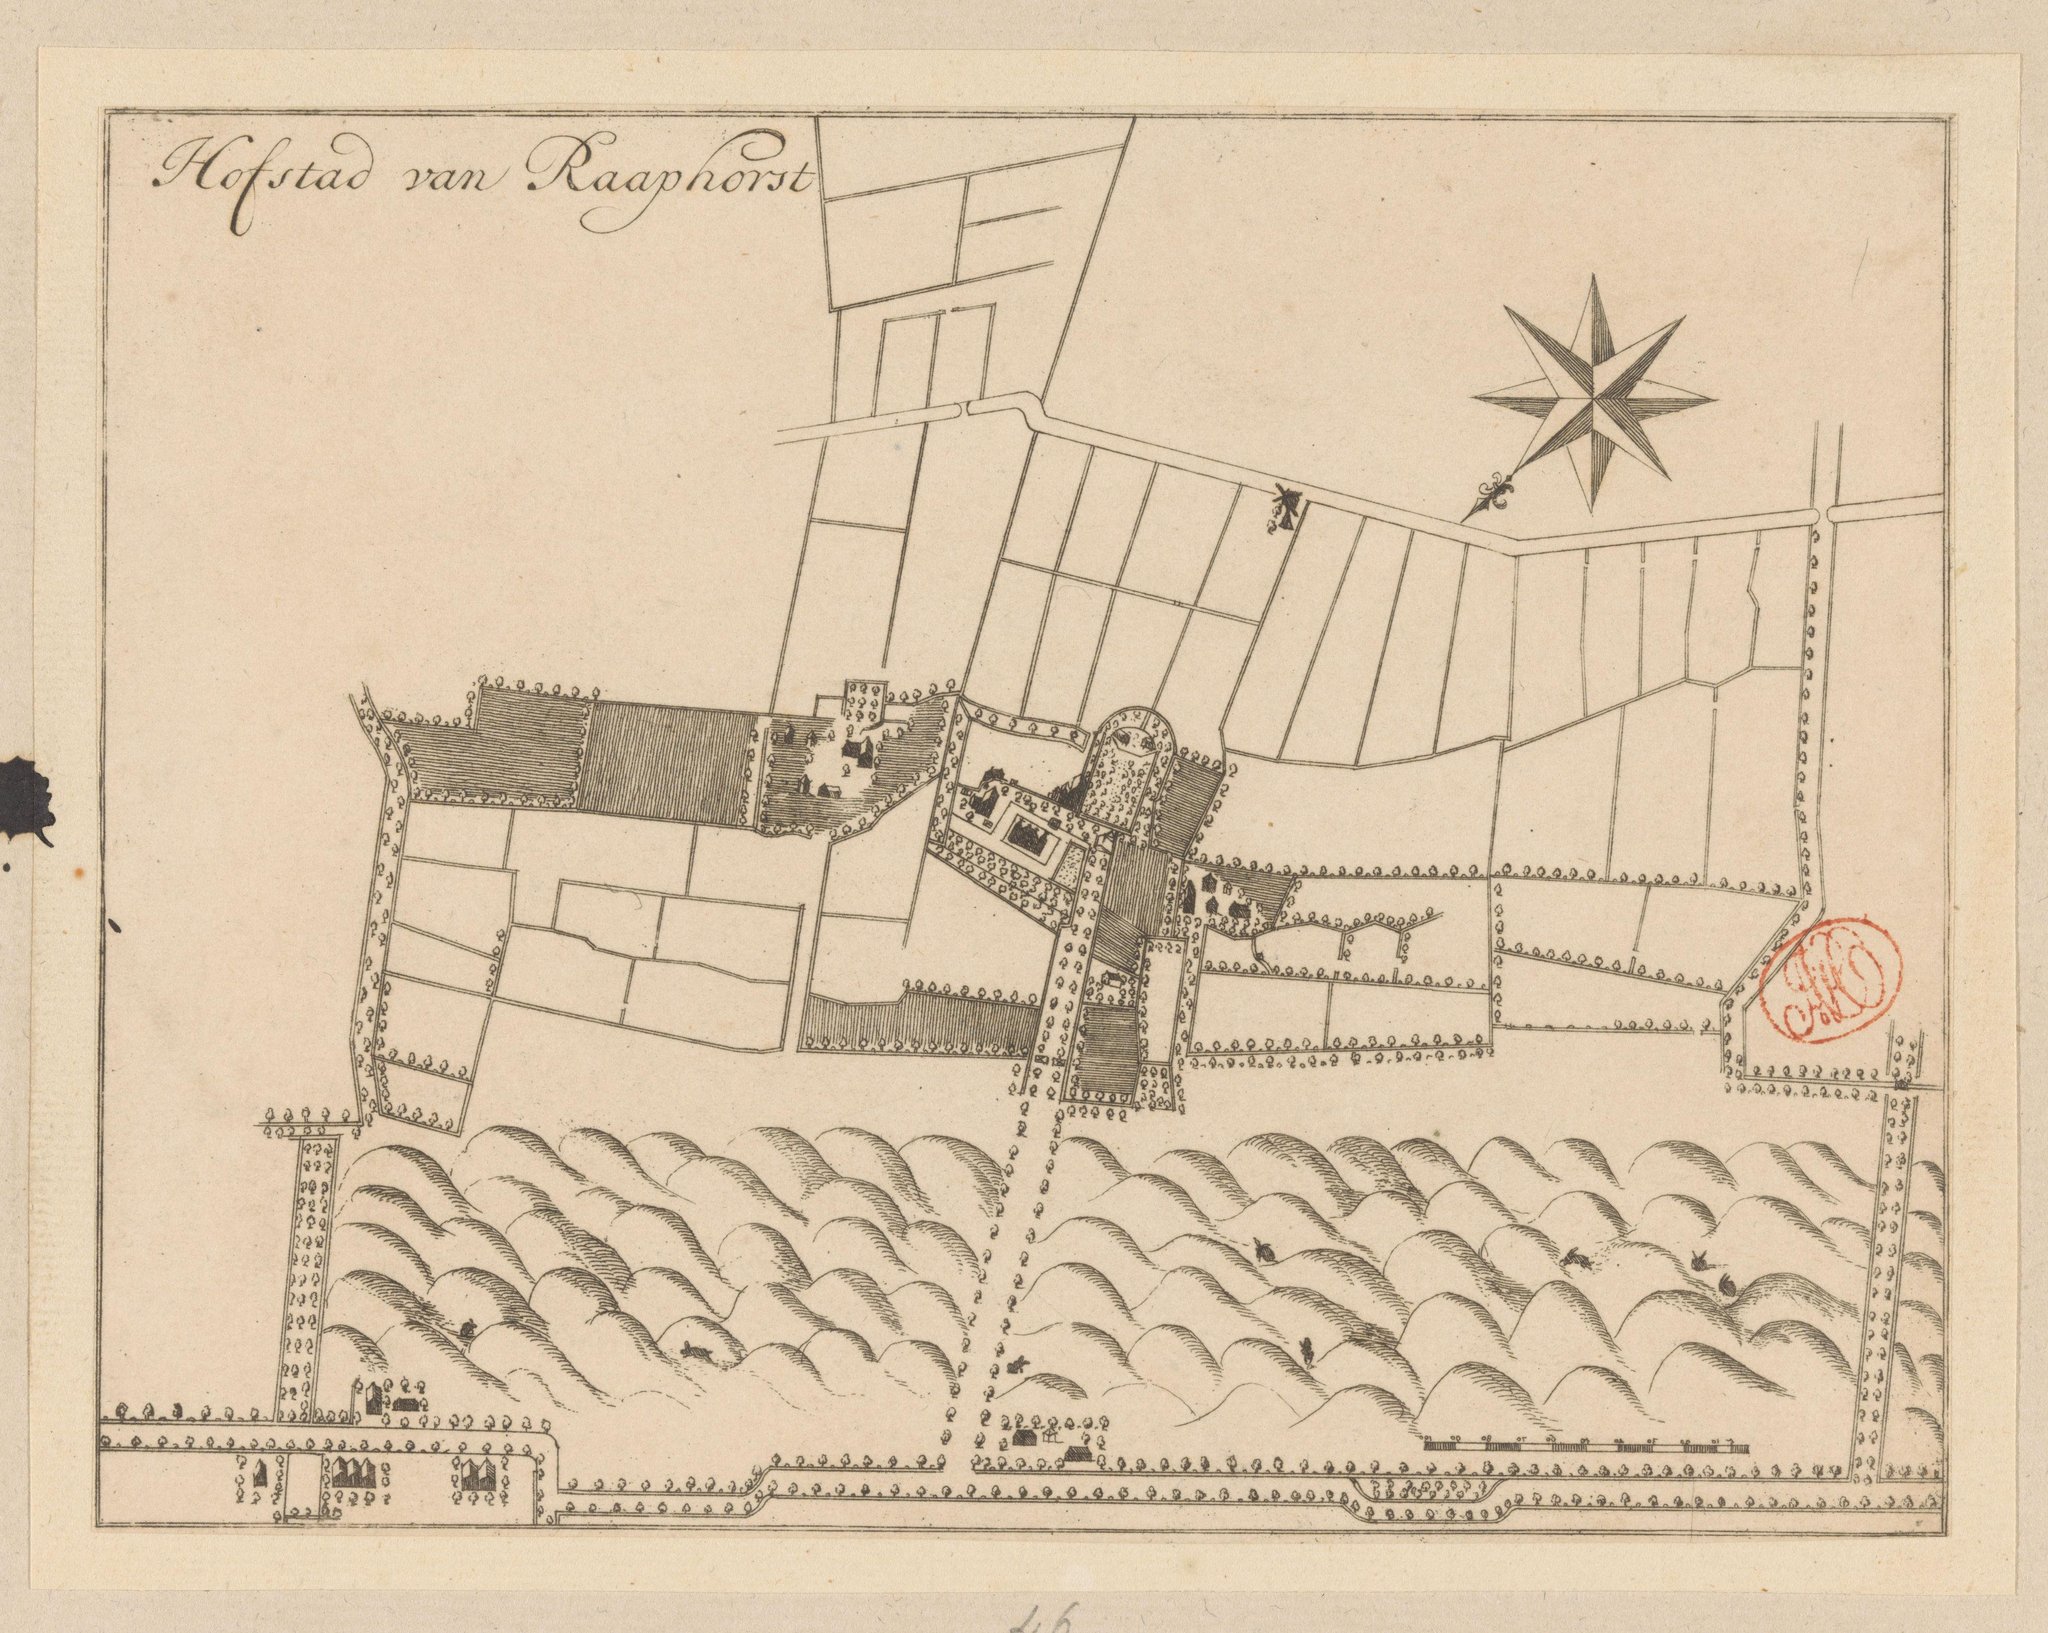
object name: print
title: Hofstad van Raaphorst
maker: Anonymous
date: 1700-1799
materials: paper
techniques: etching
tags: maps of separate countries or regions, kasteel raephorst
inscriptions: collector's mark: Lugt 195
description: Plattegrond van de hofstad Raephorst in de buurt van Wassenaar.